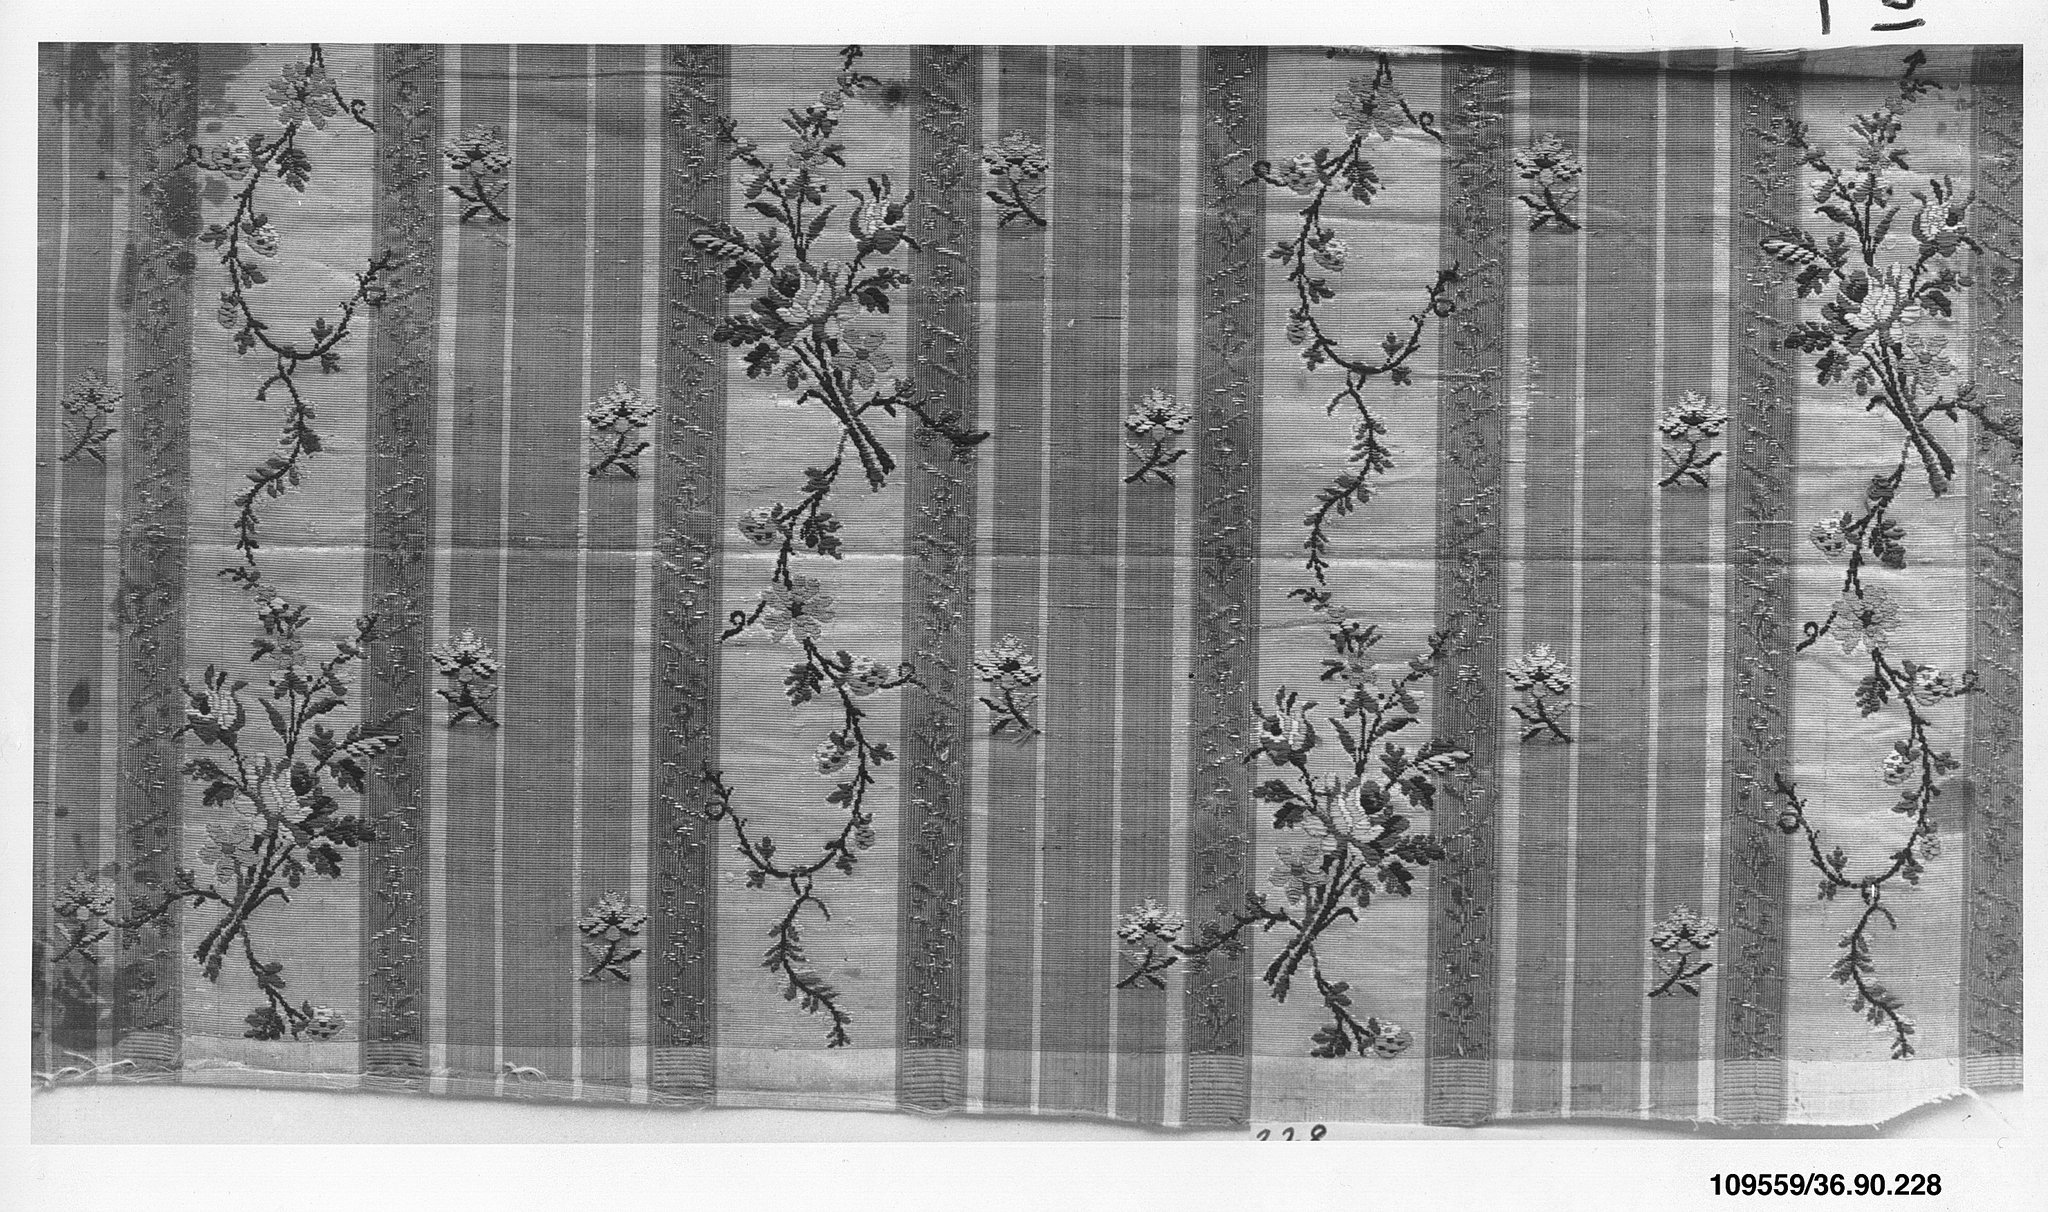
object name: piece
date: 1701-1800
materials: metal thread, silk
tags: flowers